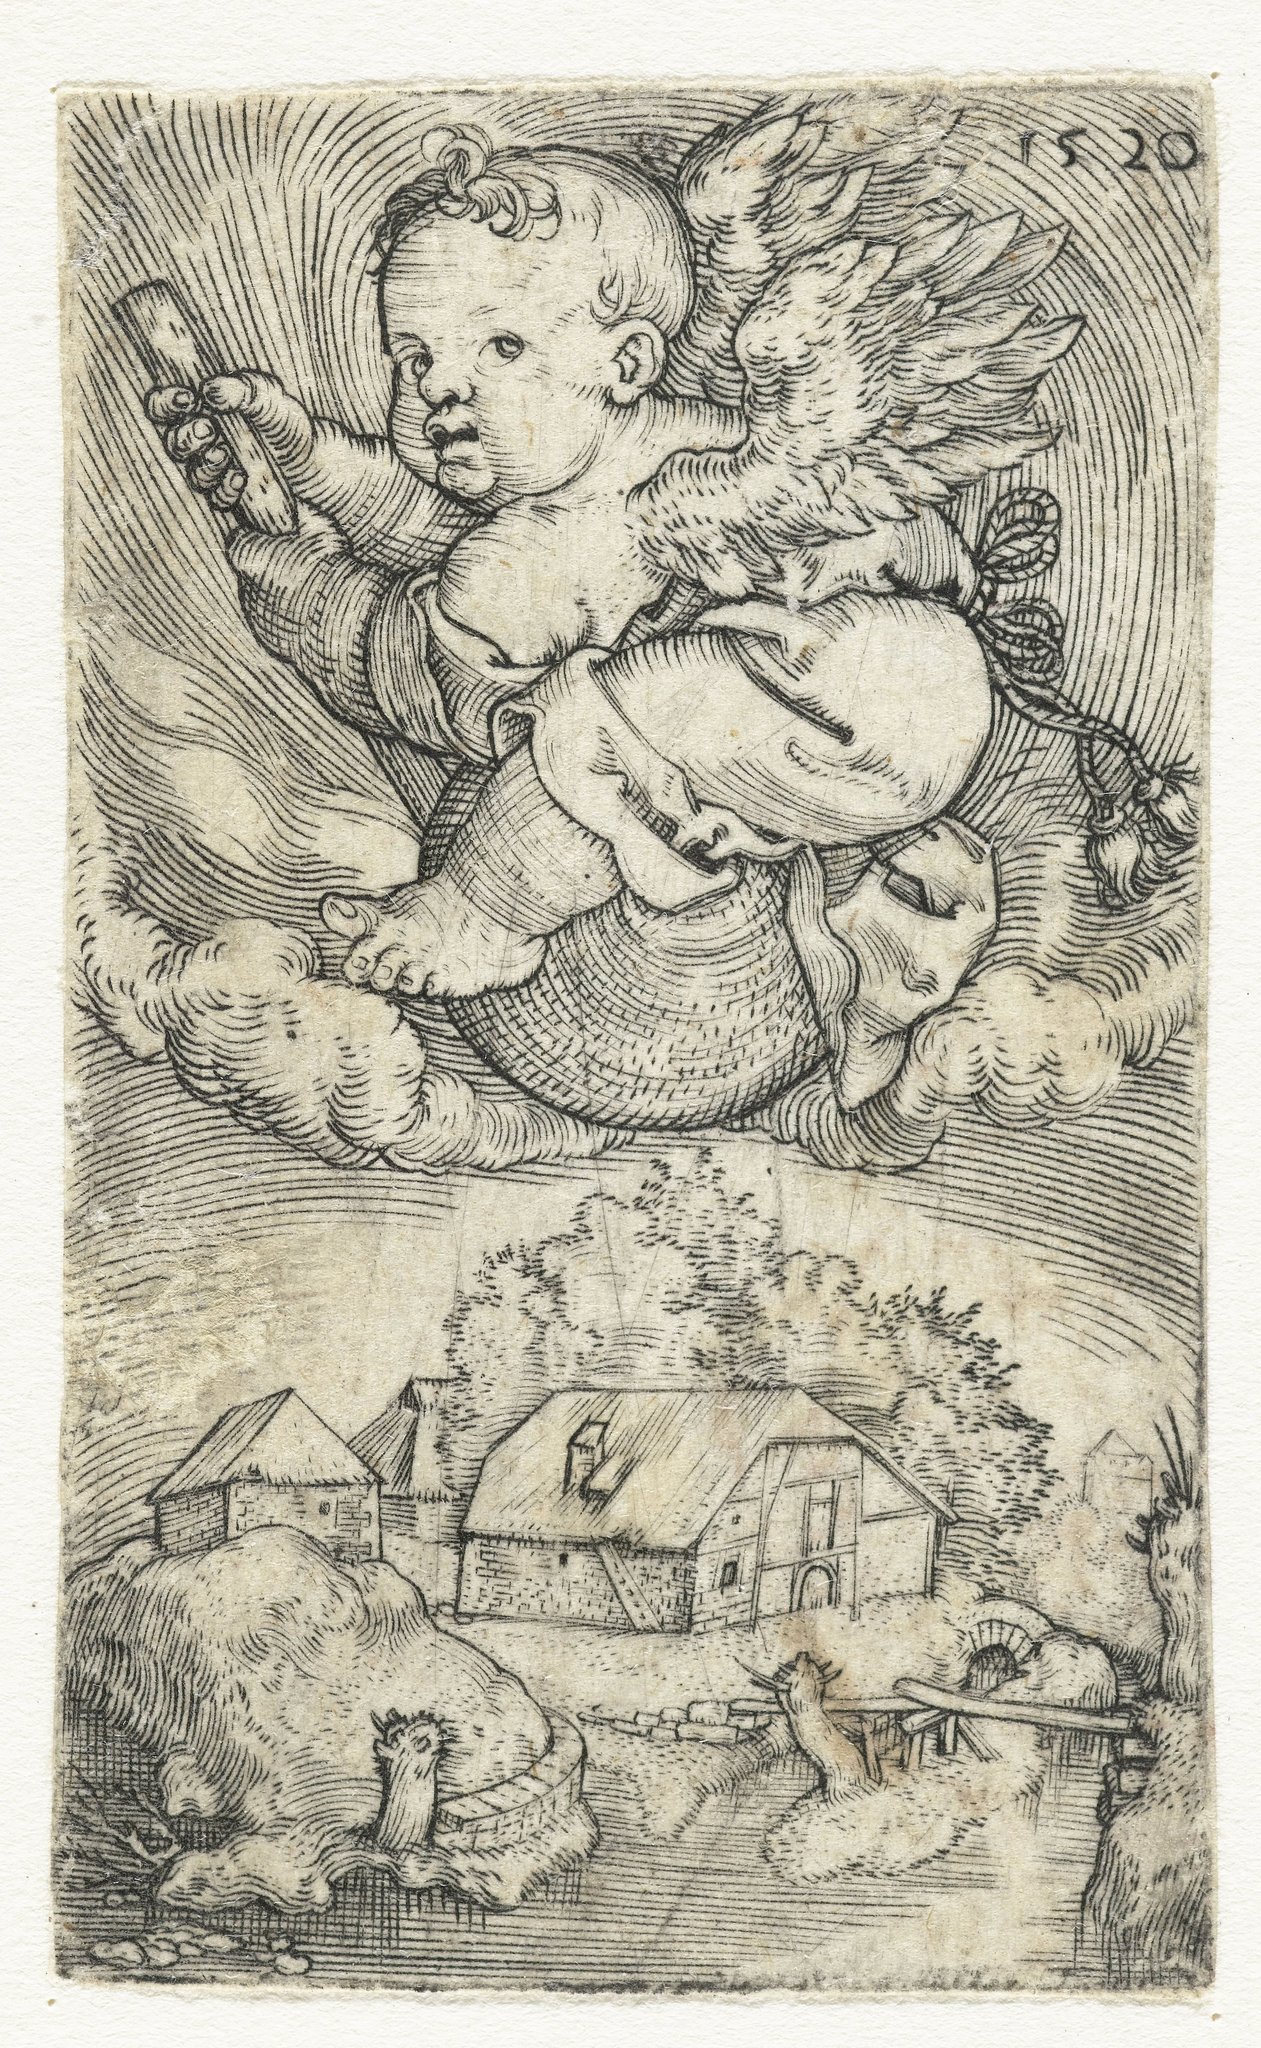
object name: print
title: Vliegende kleine engel op een bol boven landschap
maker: barthel beham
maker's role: print maker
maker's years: 1502-1540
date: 1520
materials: paper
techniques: engraving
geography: nuremberg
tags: angels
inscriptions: collector's mark: Lugt 240